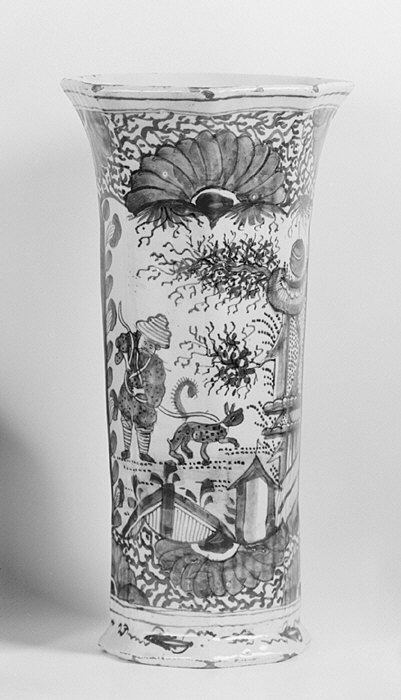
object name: beaker with lid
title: Beaker with lid (part of a garniture)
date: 1701-1800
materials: earthenware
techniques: glazing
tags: animals,chinoiserie,men